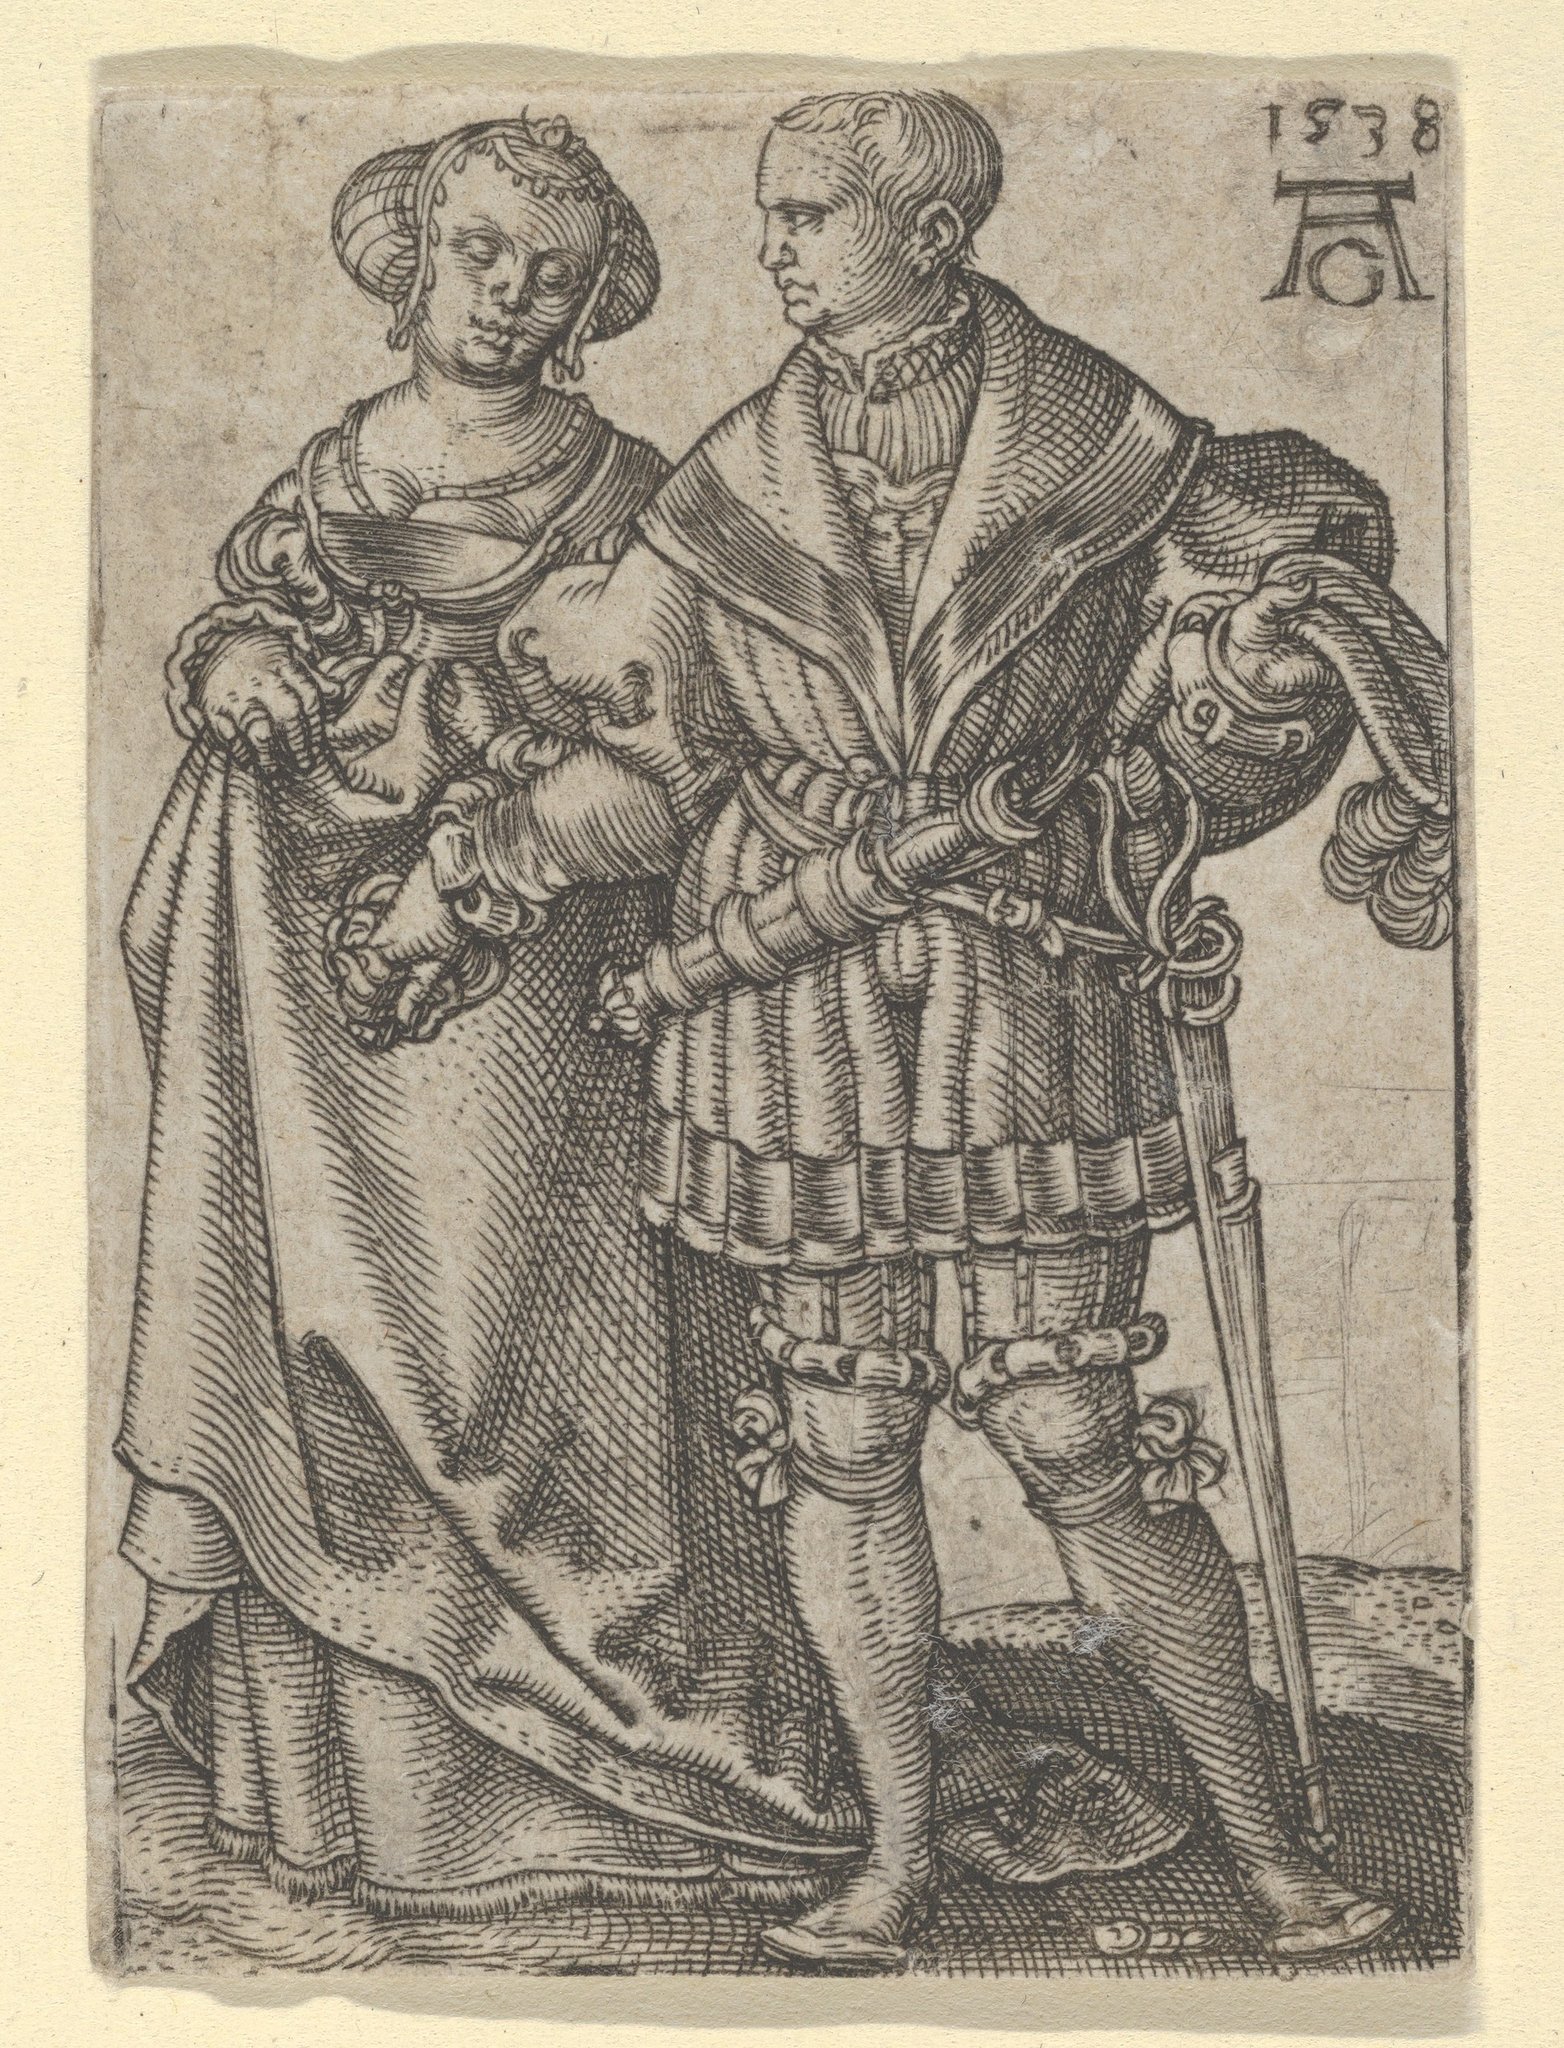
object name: print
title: Dancing Couple, from "The Small Wedding Dancers"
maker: heinrich aldegrever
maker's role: artist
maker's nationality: german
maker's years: 1502-1561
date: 1538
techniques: engraving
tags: couples,men,women,dancing